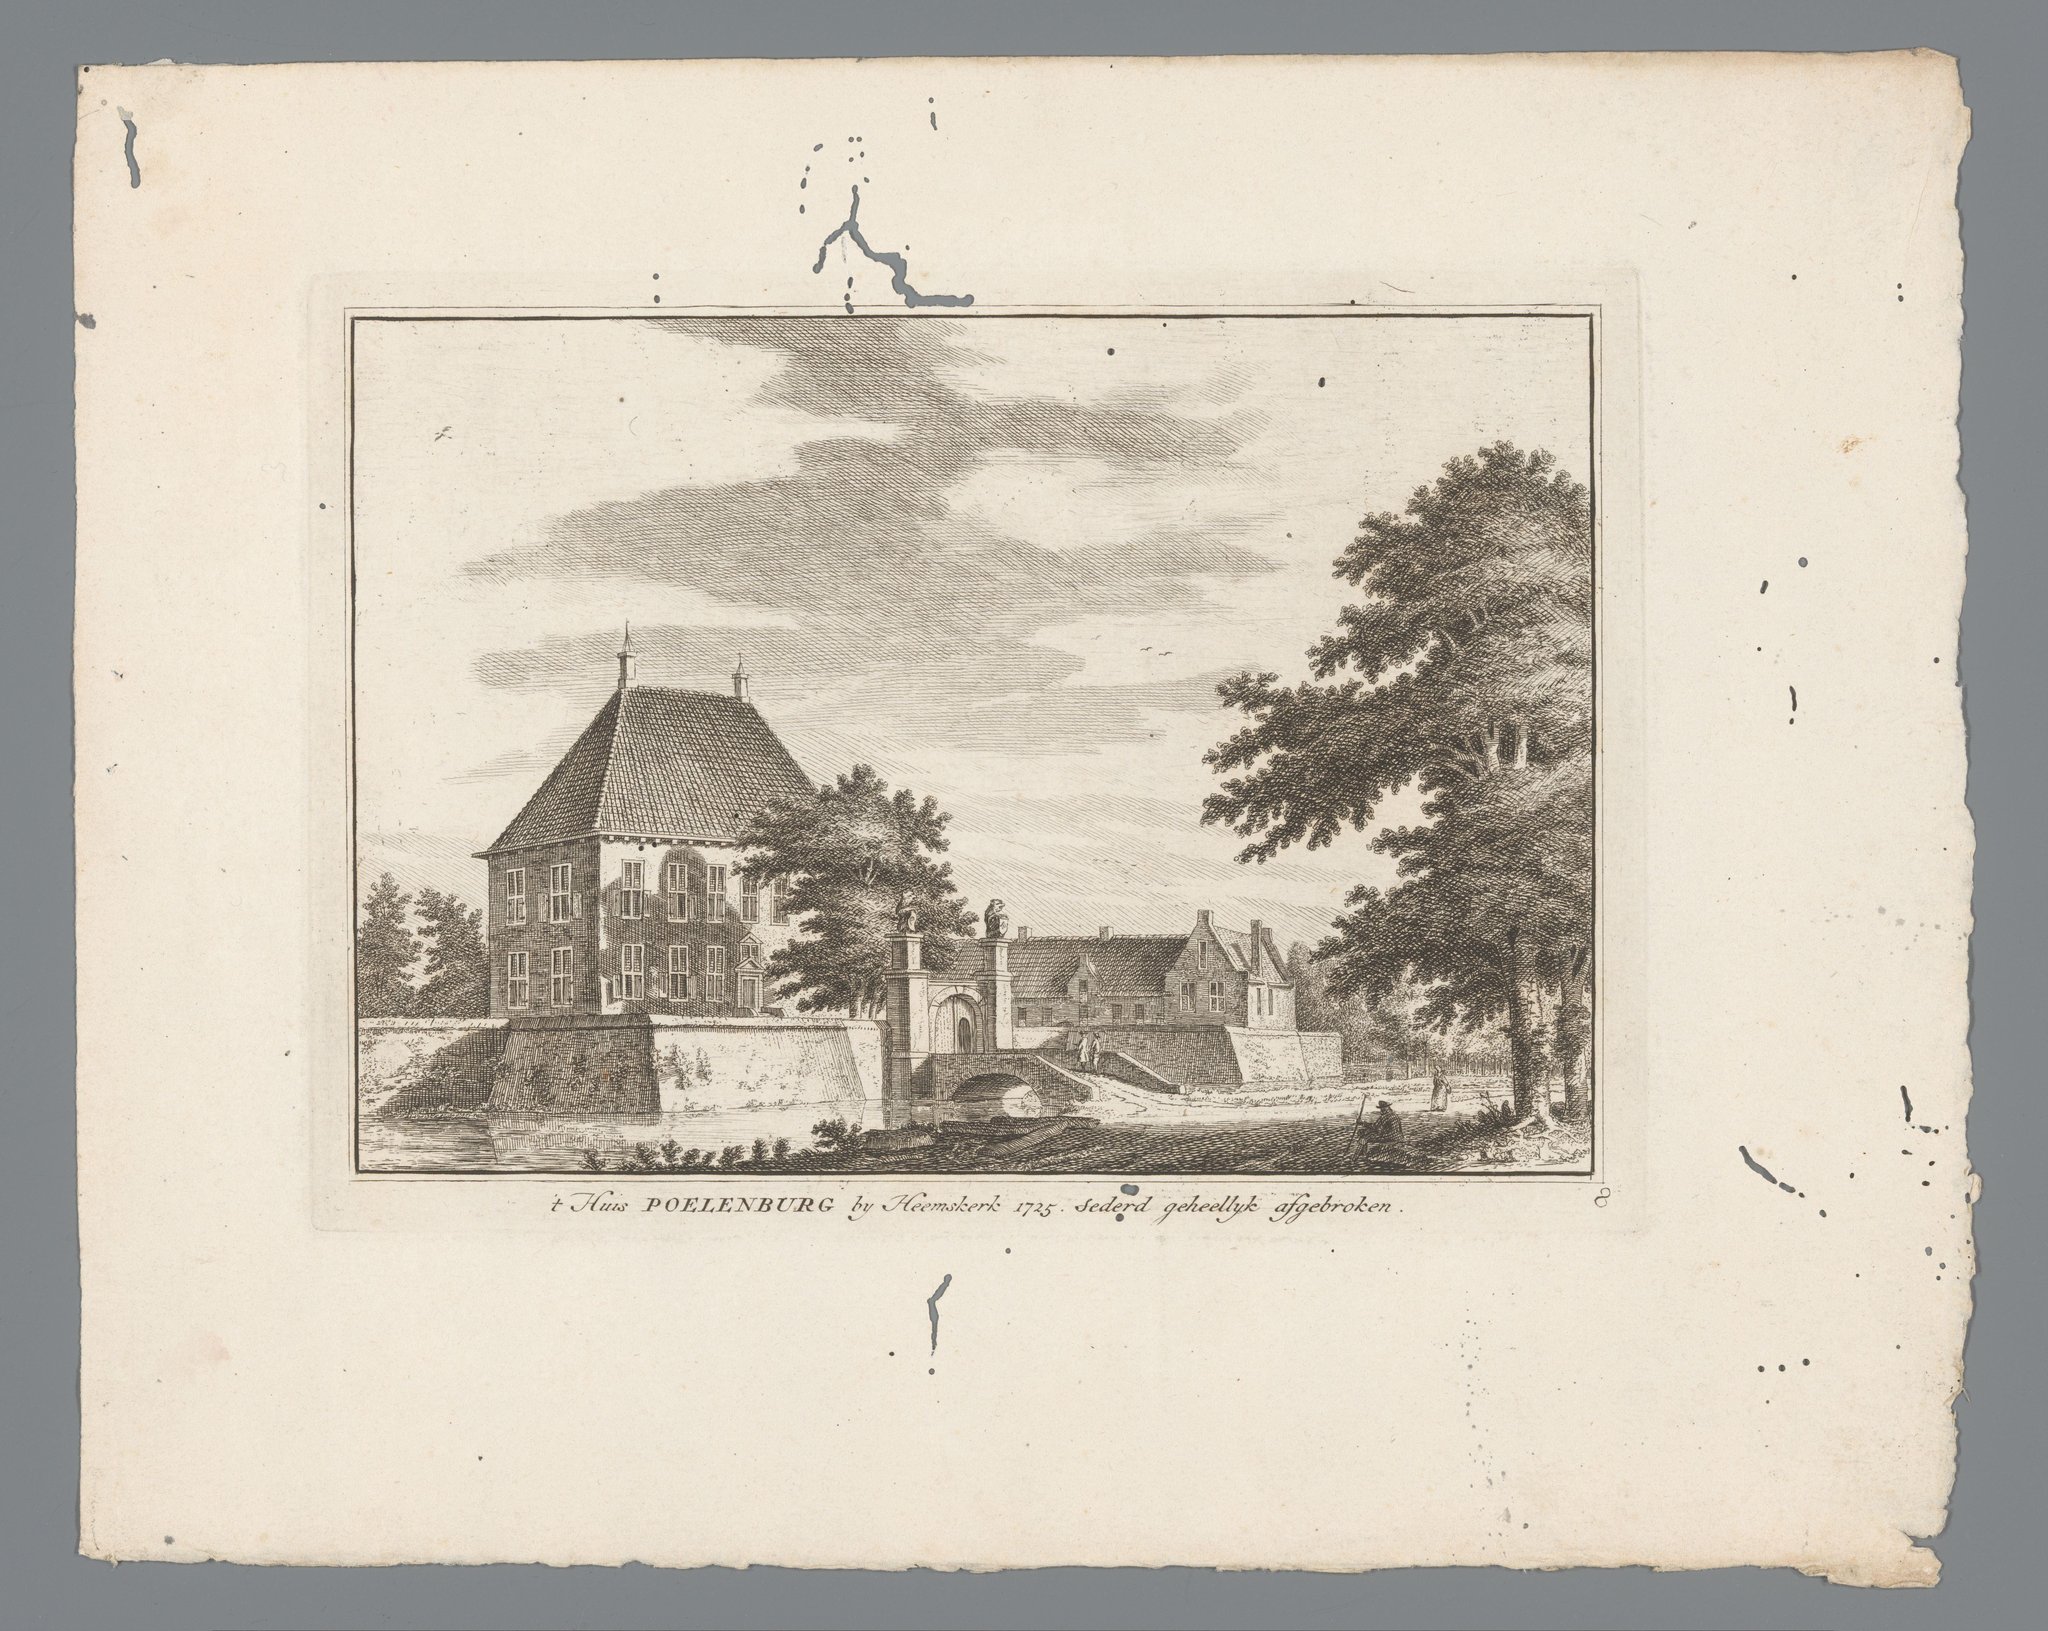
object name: print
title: Kennemerlandse gezichten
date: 1739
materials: paper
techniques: etching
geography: amsterdam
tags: canal, villa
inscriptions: collector's mark: Lugt 2228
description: Prent uit: Kennemerlandsche Gezichten. S.l.s.n., 1739. Sommige latere uitgaves van deze serie hebben het adres van Pierre Fouquet in Amsterdam.